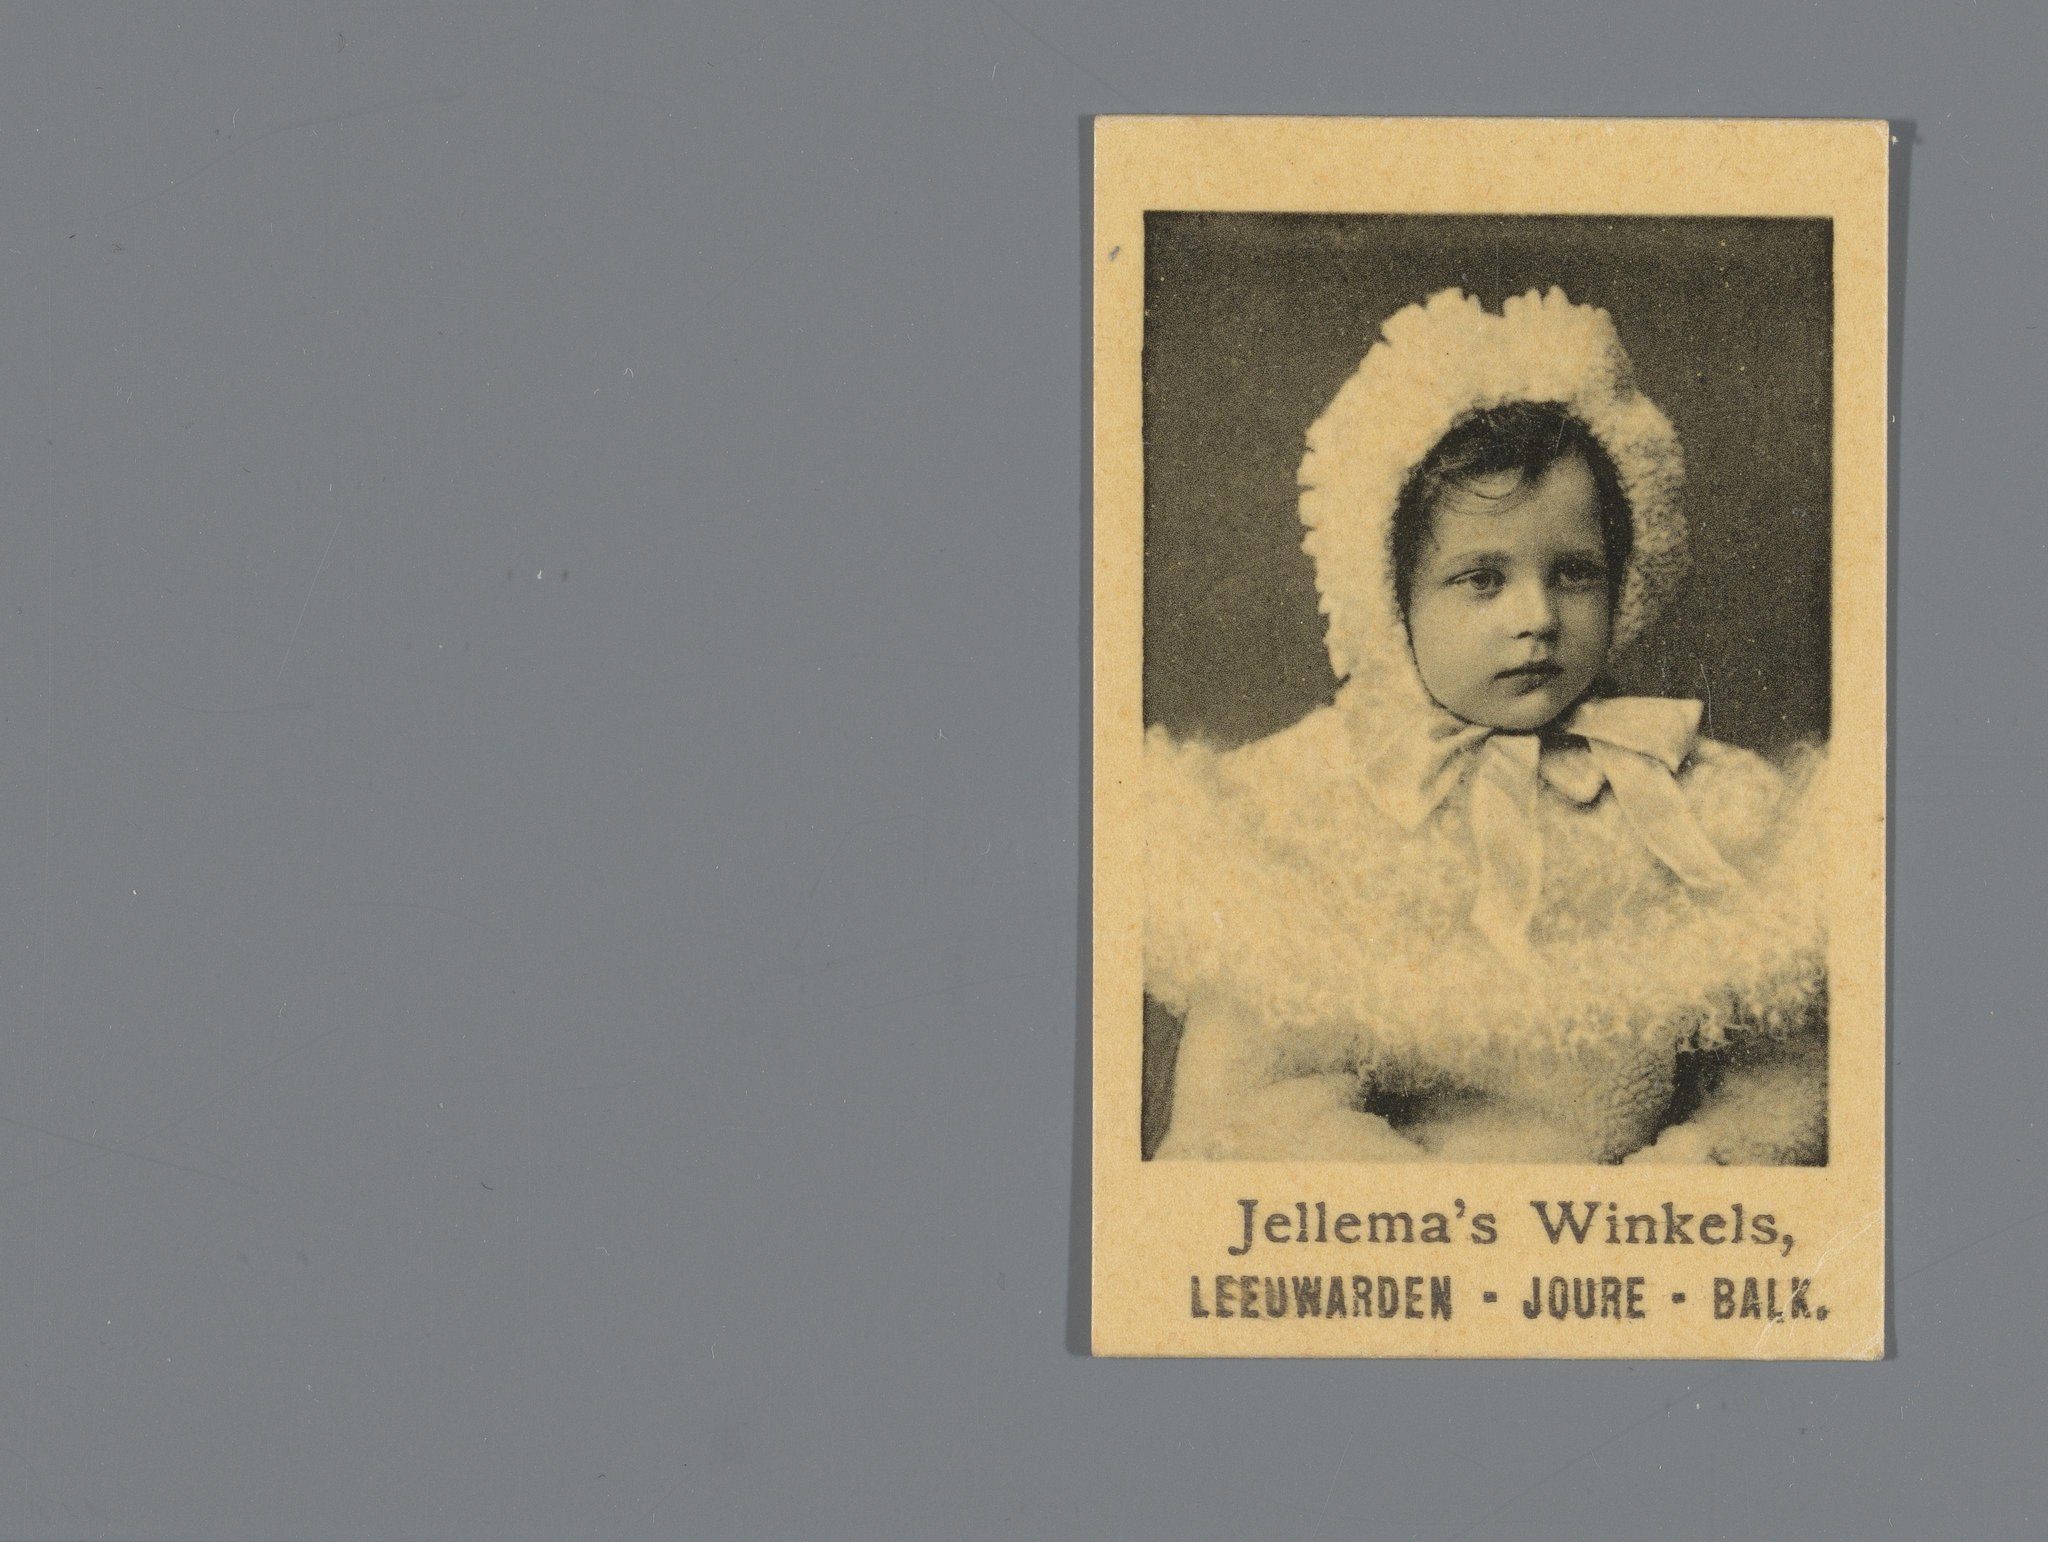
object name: photomechanical print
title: Portret van een onbekend jong meisje met hoofddeksel, reclame voor Jellema's winkels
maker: Anonymous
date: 1895-1910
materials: paper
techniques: photograph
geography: netherlands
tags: girl (child between toddler and youth), anonymous historical person portrayed, netherlands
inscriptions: inscription: ‘LEEUWARDEN - JOURE - BALK.’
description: Dergelijke prenten stonden bekend als 'zwartjes'. Men verkreeg ze bij aanschaf van bepaalde merken thee, cacao, sigaretten, beschuit, etc. om te verzamelen. Er waren speciaal voor de 'zwartjes' verzamelalbums in omloop.